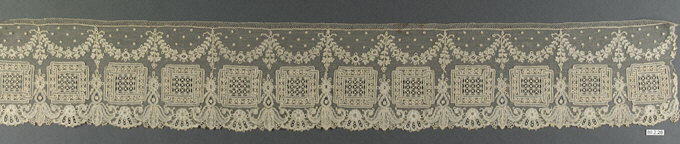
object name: fragment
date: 1860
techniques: lace